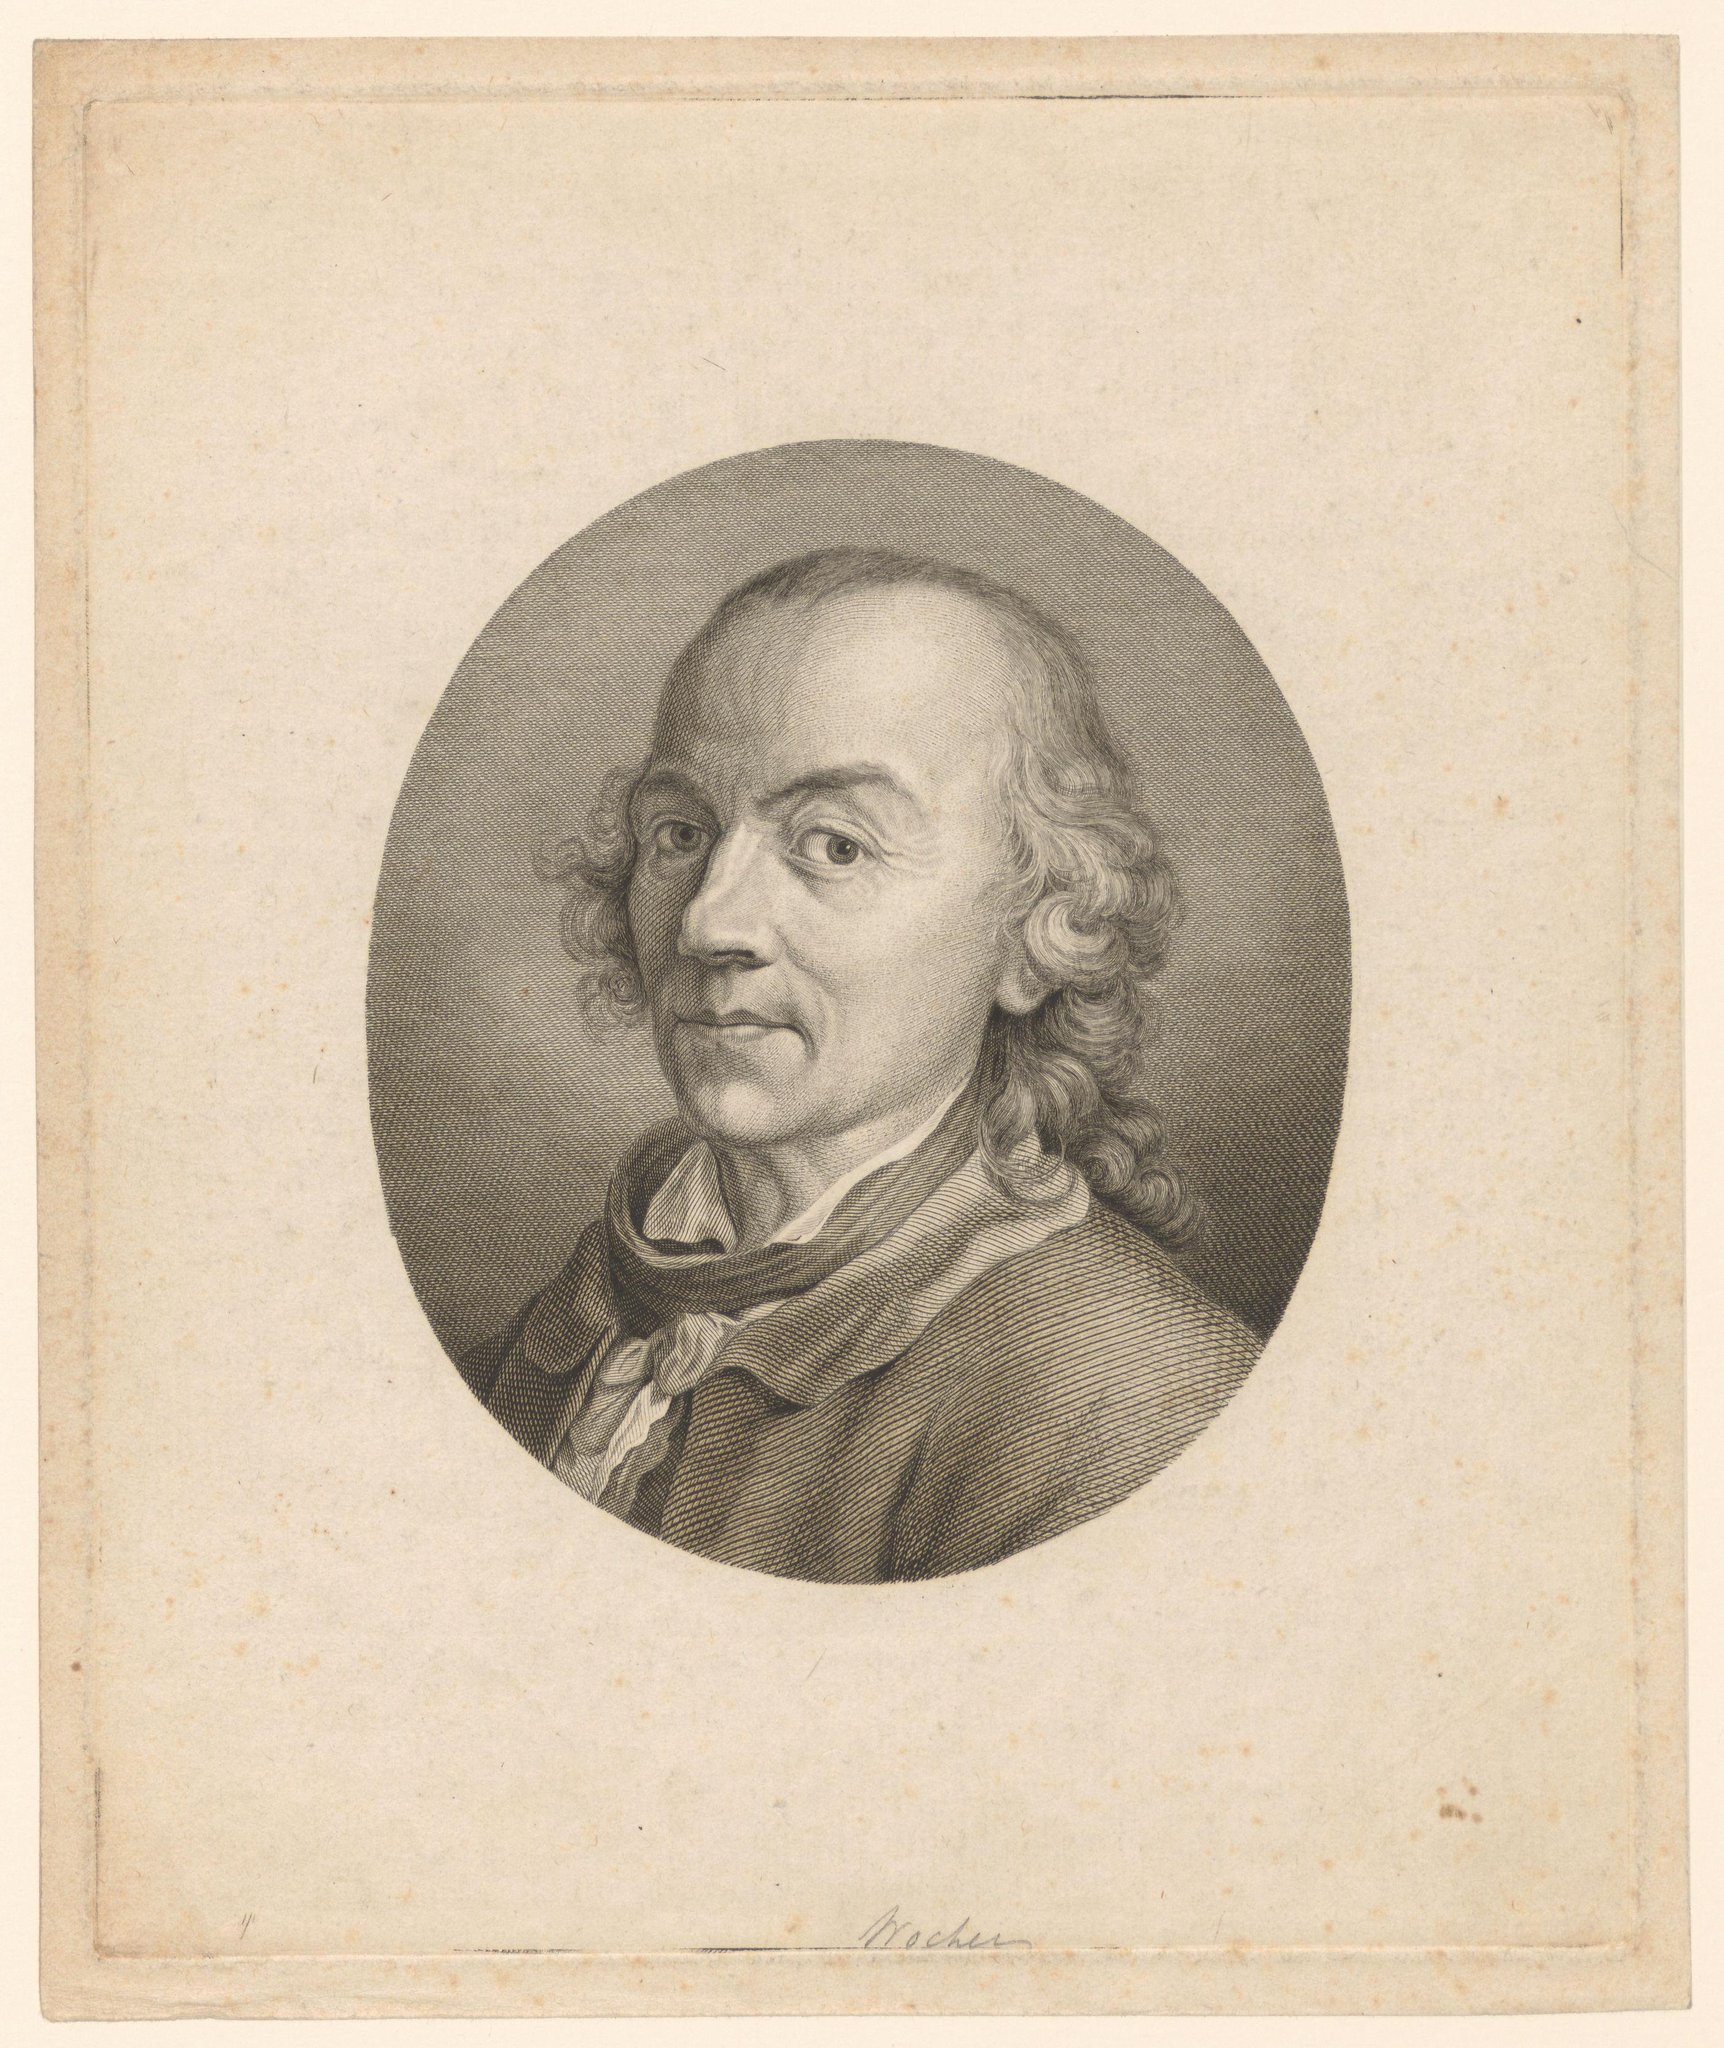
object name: print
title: Portret van Tiberius Dominikus Wocher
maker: john hall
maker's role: print maker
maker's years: 1739-1797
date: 1768-1797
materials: paper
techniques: engraving, etching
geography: great britain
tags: painter, tiberius dominikus wocher, historical persons, portrait, self-portrait of painter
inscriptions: collector's mark: Lugt 2228